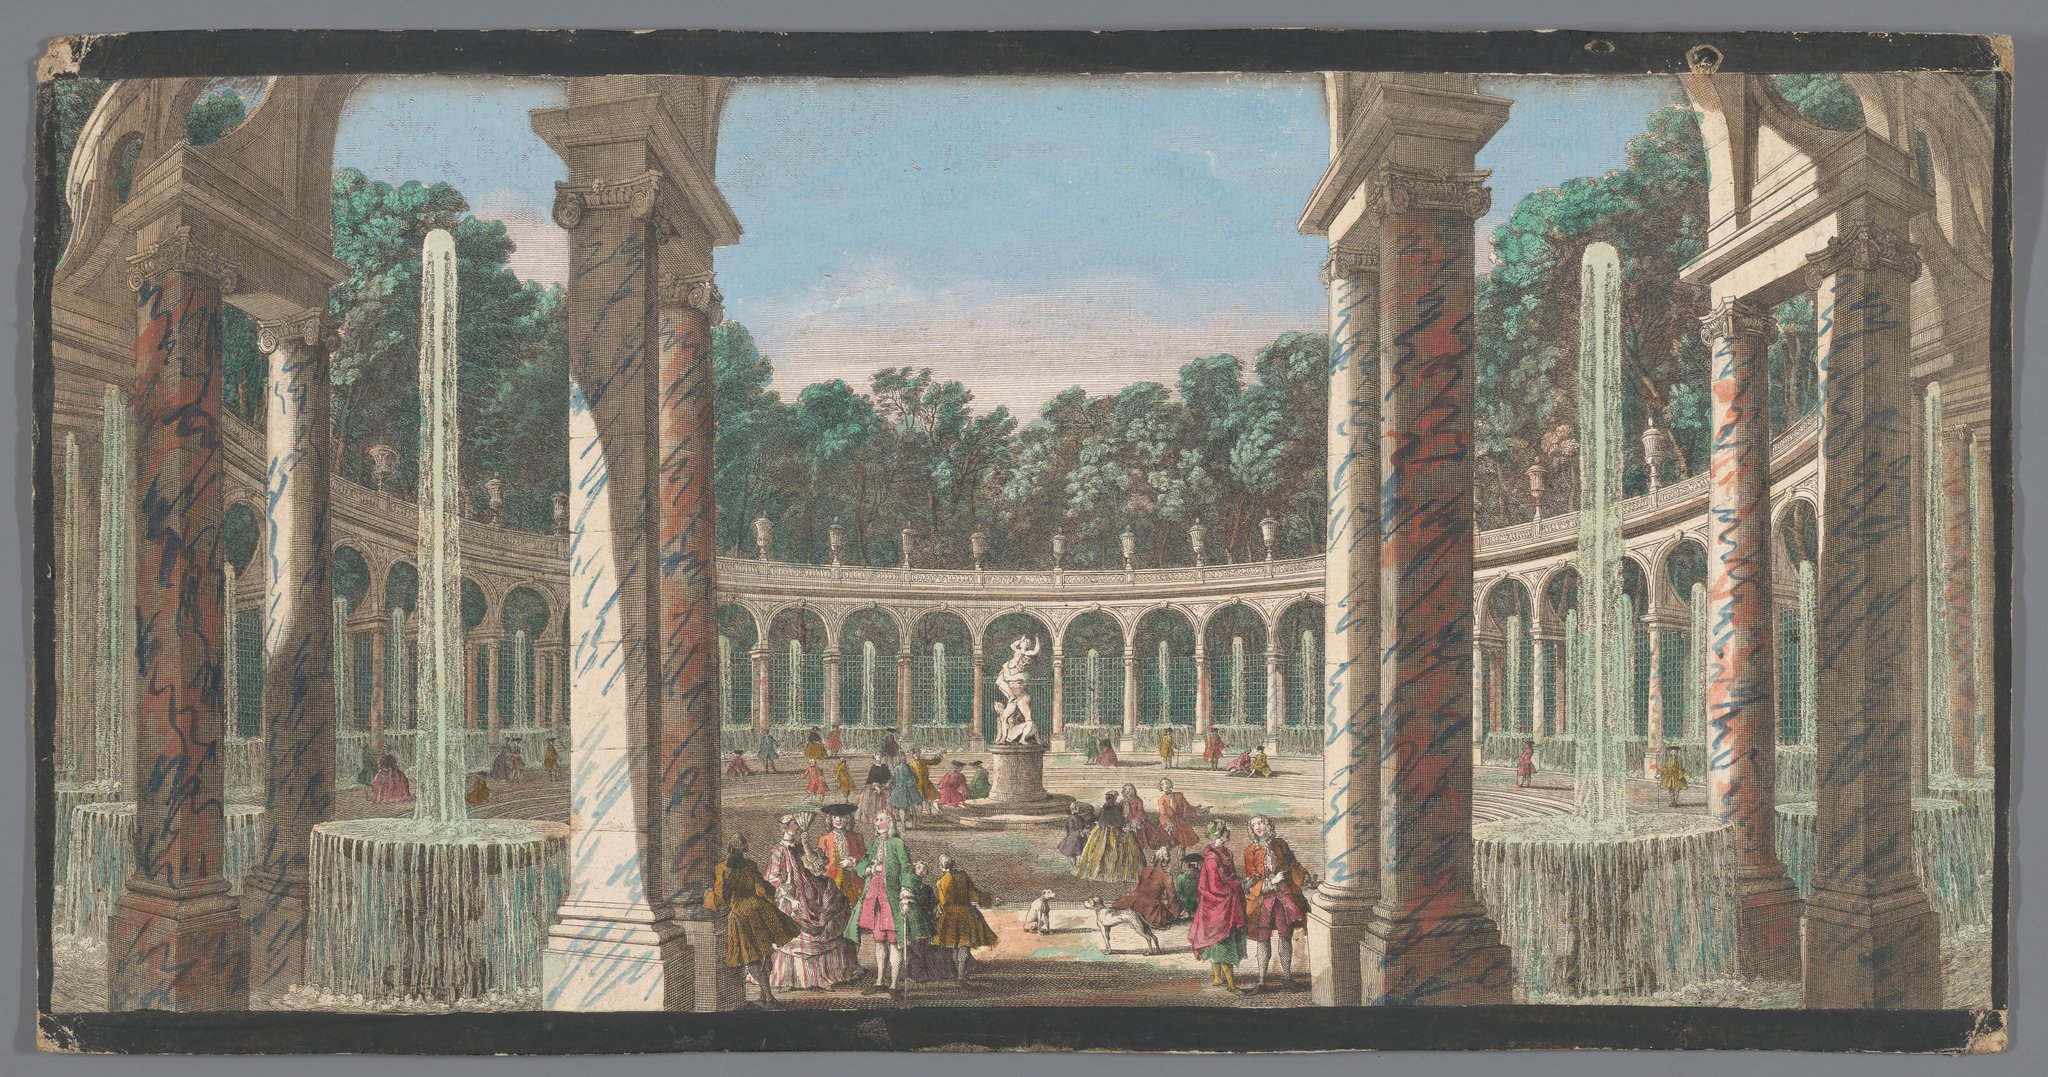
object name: print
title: La Colonnade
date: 1700-1799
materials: cardboard, paper, watercolor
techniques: brush, etching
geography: paris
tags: garden, garden fountain, garden ornaments, garden buildings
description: In de ondermarge twee regels Franse tekst.